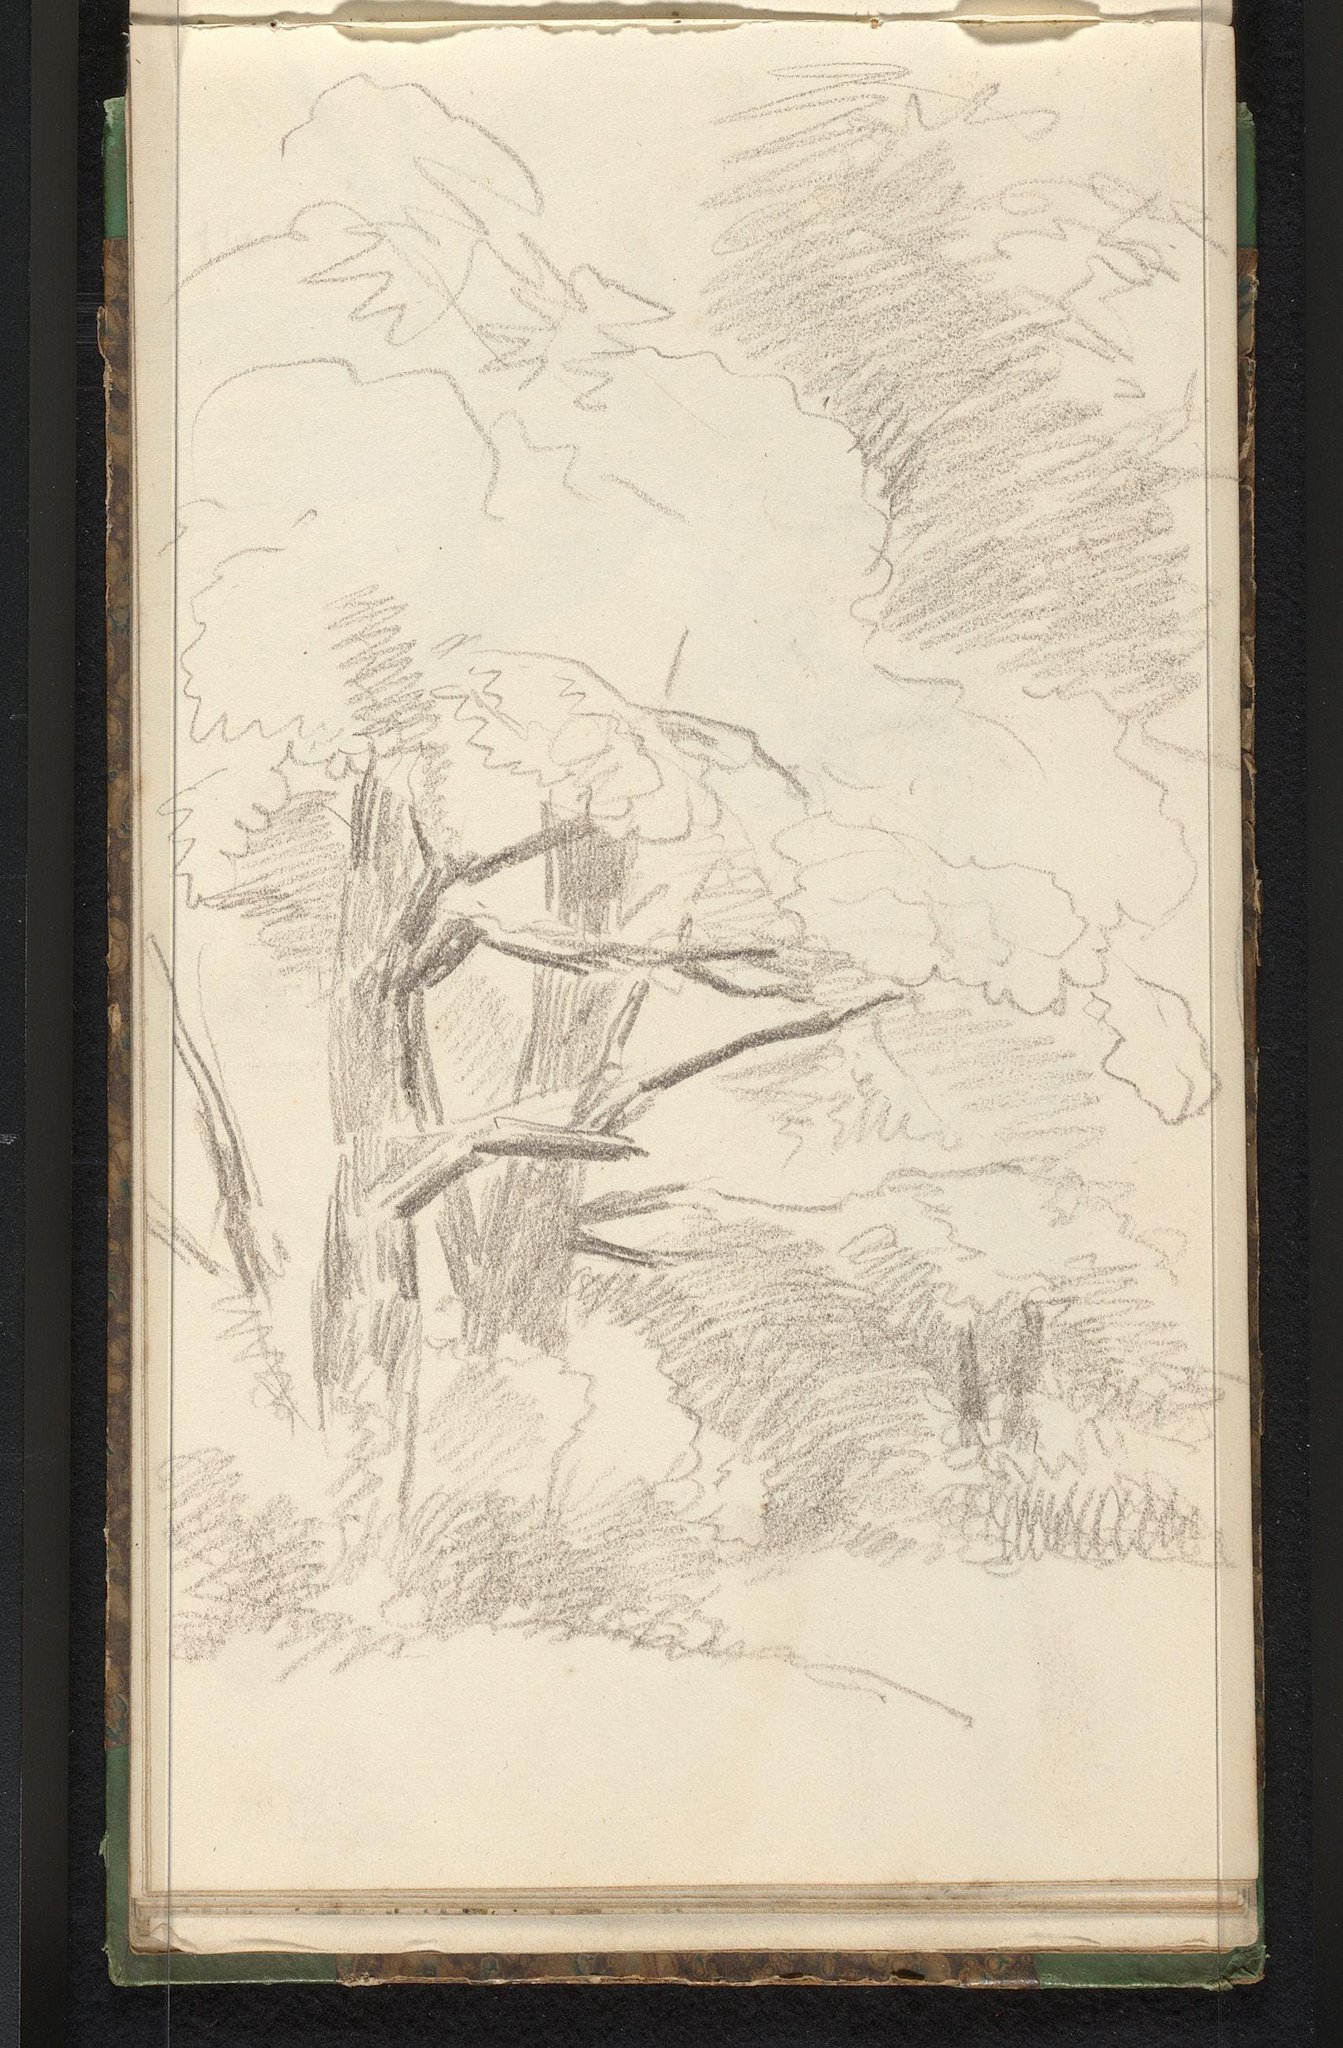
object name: sketchbook leaf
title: Bomen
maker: jan bedijs tom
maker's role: draughtsman, painter, print maker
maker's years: 1813-1894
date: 1828-1894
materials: paper, pencil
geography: the hague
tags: trees, landscapes, artist (in general) making preliminary designs, sketching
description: Pagina 29 verso uit een schetsboek met 50 bladen.